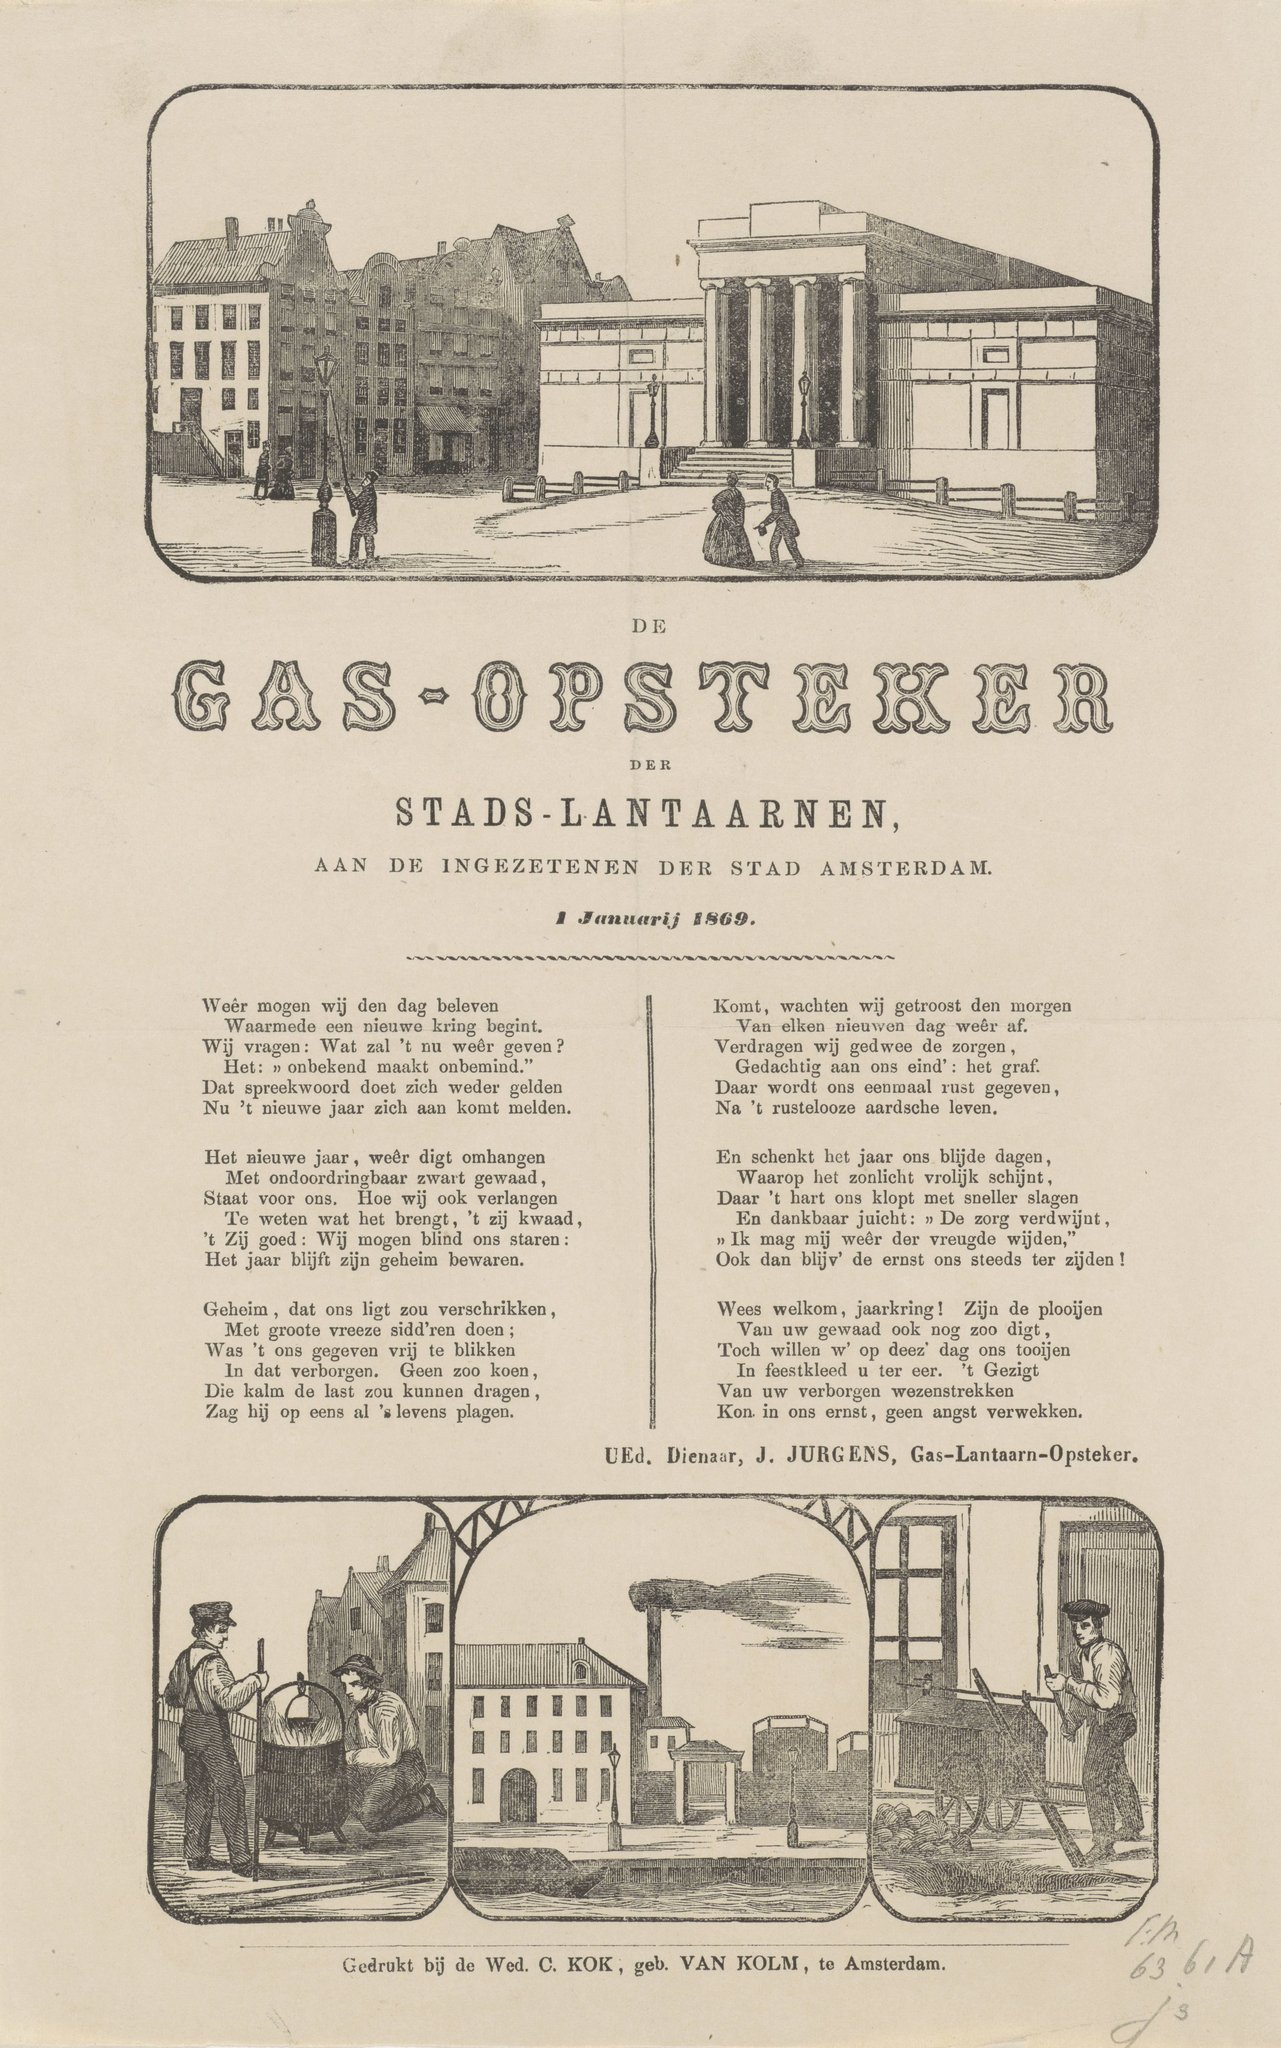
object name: new year card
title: De Gas-opsteker der Stads-lantaarnen, aan de ingezetenen der stad Amsterdam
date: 1868-1869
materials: paper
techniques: letterpress printing, engraving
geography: amsterdam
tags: gas-lamp (+ kindling a light; lit, burning light, lamp, candle), gas supply, street lighting, street, amsterdam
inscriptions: collector's mark: Lugt 2228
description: Nieuwjaarswens van de Amsterdamse gaslantaarnopstekers voor het jaar 1869. Centraal een vers in twee kolommen. Bovenaan de Dam met de beurs van Zocher te Amsterdam. Onderaan de Hollandsche Gasfabriek en twee gasfitters aan het werk. Van de gaslantaarnopsteker: J. Jurgens.